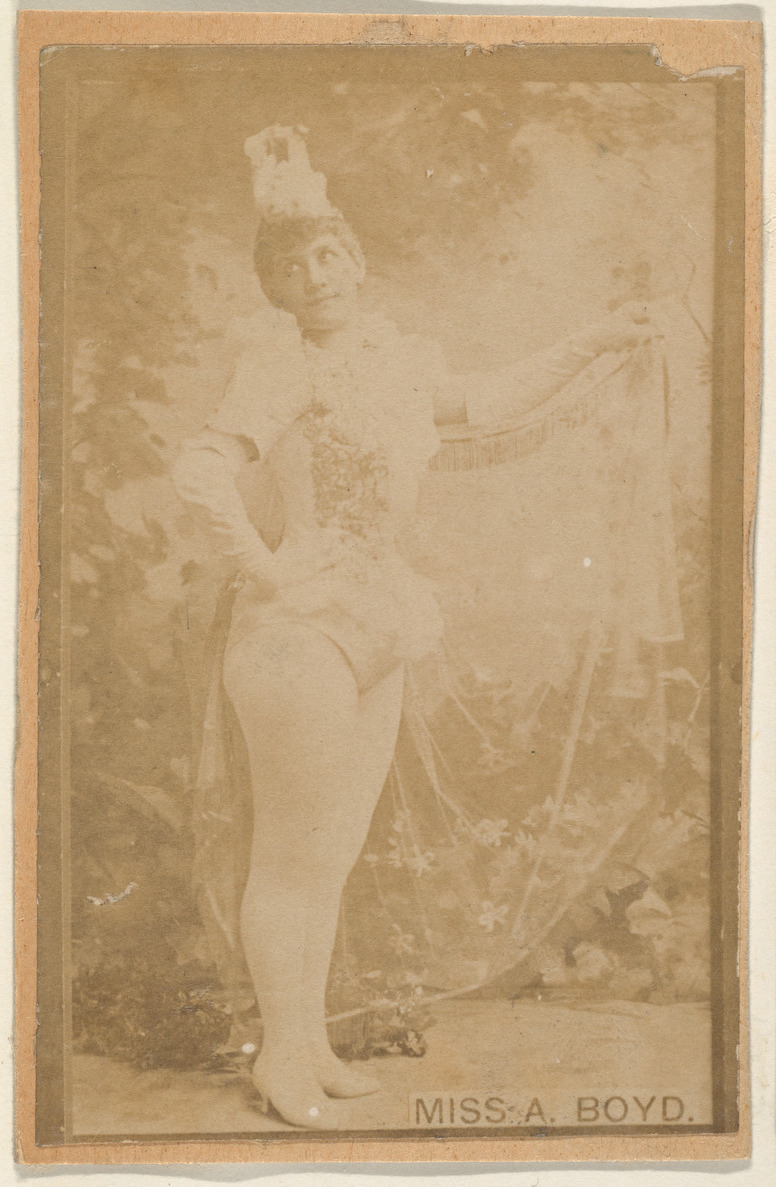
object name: photograph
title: Miss A. Boyd, from the Actresses series (N668)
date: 1888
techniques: albumen silver print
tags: portraits,women,actresses